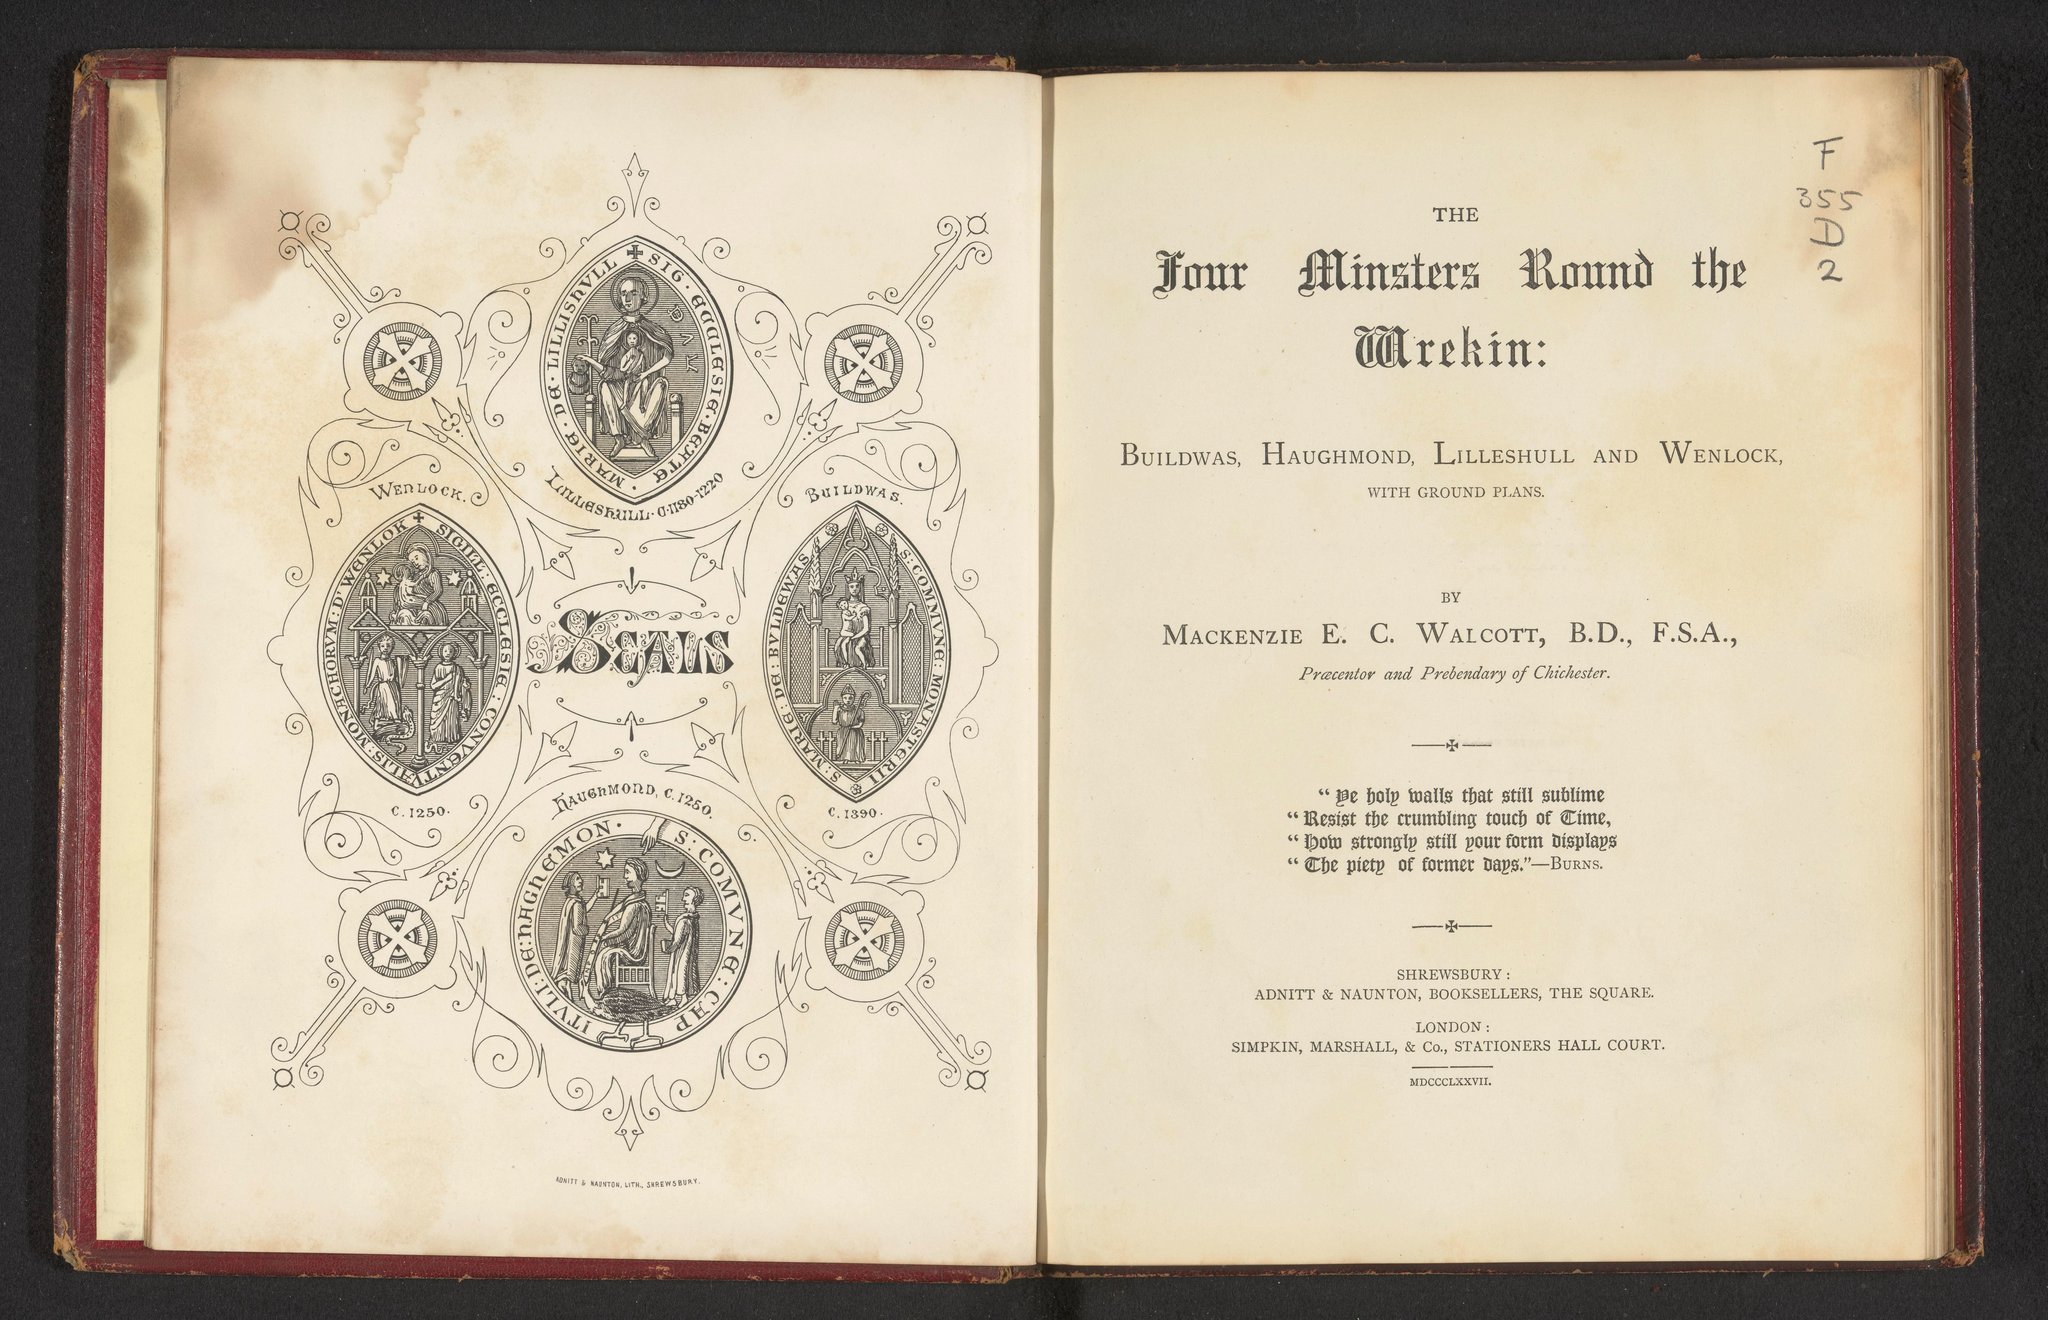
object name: book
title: The four ministers round the Wrekin Buildwas, Haughmond, Lilleshull and Wenlock, with ground plans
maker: mackenzie edward charles walcott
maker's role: kerkhistoricus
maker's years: 1821-1880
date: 1877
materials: leather, paper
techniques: photograph, printing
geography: shrewsbury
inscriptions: name: ‘SPe Labor Levis Sir David F. Ochterlong Bar’, name: ‘ex libris SFJ’